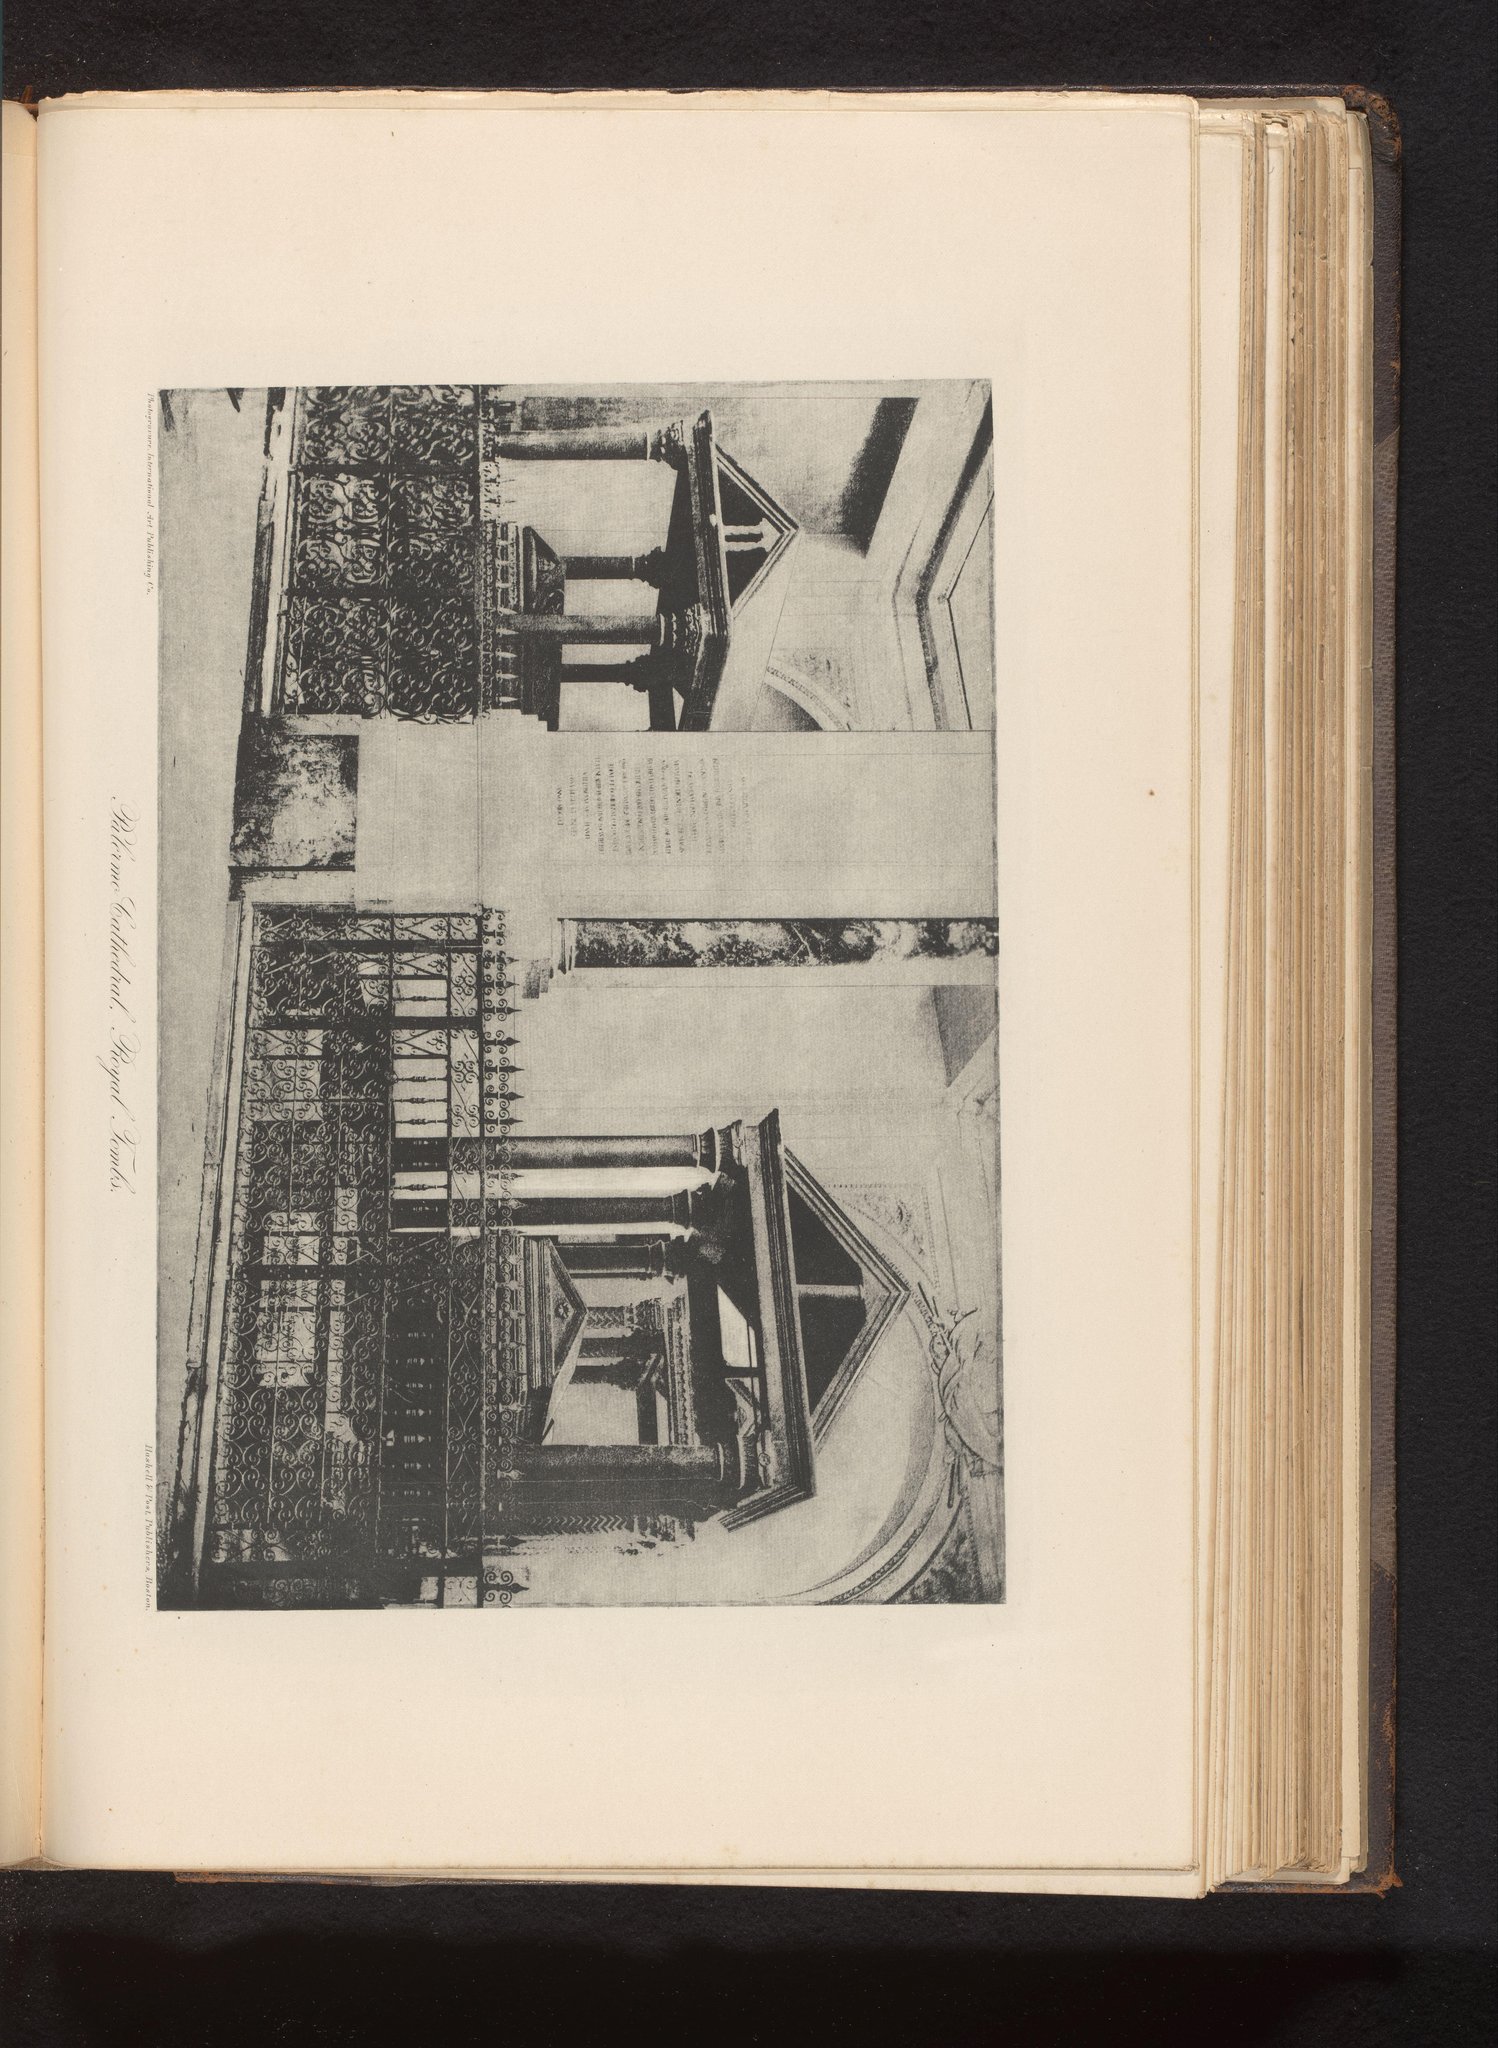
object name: photomechanical print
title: Palermo Cathedral, royal tombs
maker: Anonymous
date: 1881-1886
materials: paper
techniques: photograph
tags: interior of church, grave-building, monumental tomb